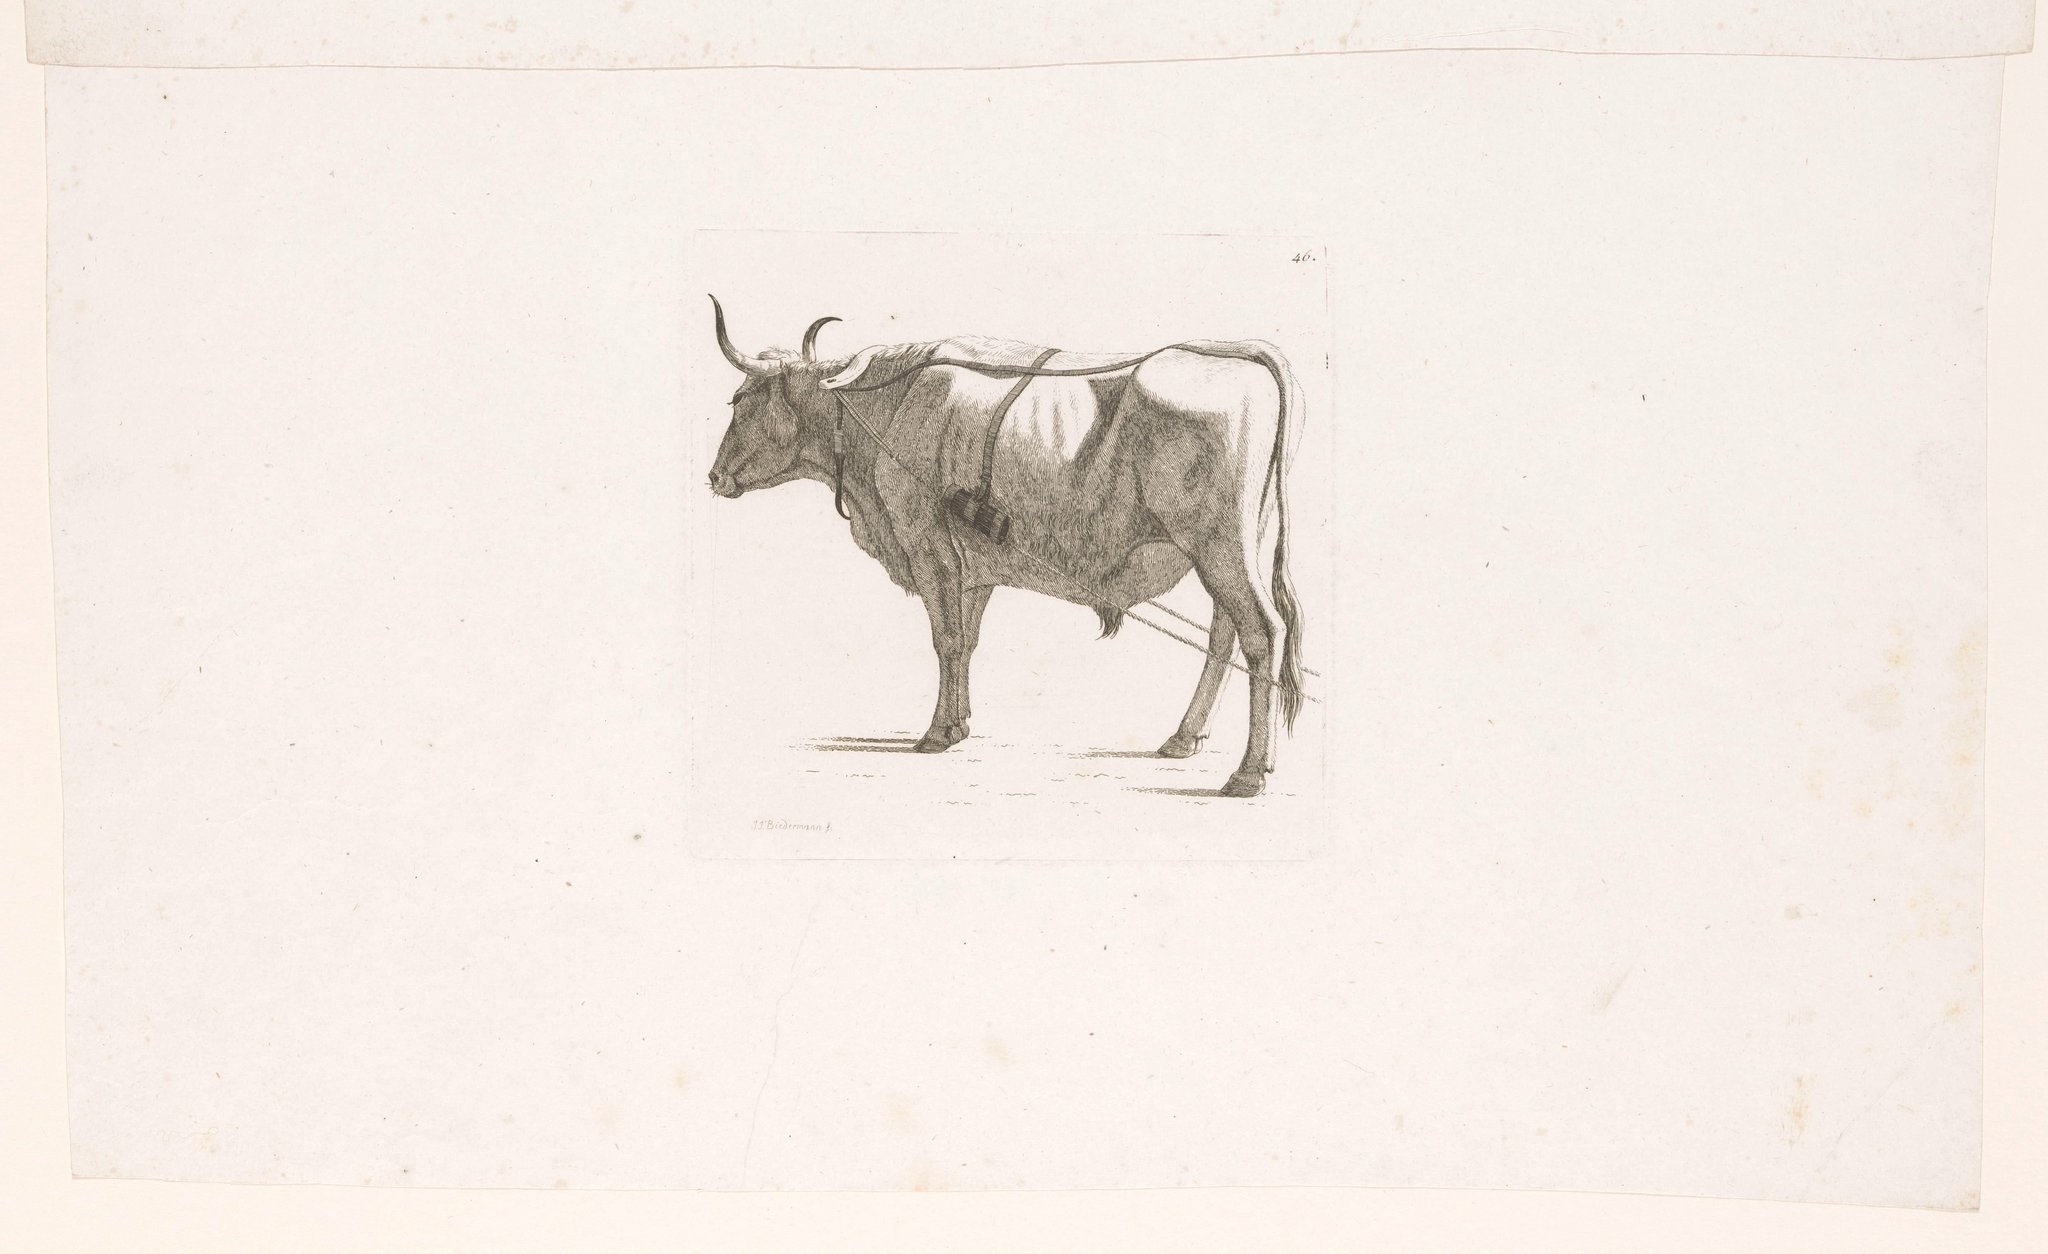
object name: print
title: Staande os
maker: johan jakob biedermann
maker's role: painter, print maker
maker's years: 1763-1830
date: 1778-1830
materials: paper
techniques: etching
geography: switzerland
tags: ox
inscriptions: collector's mark: Lugt 2228, watermark: ‘Thurneisen’